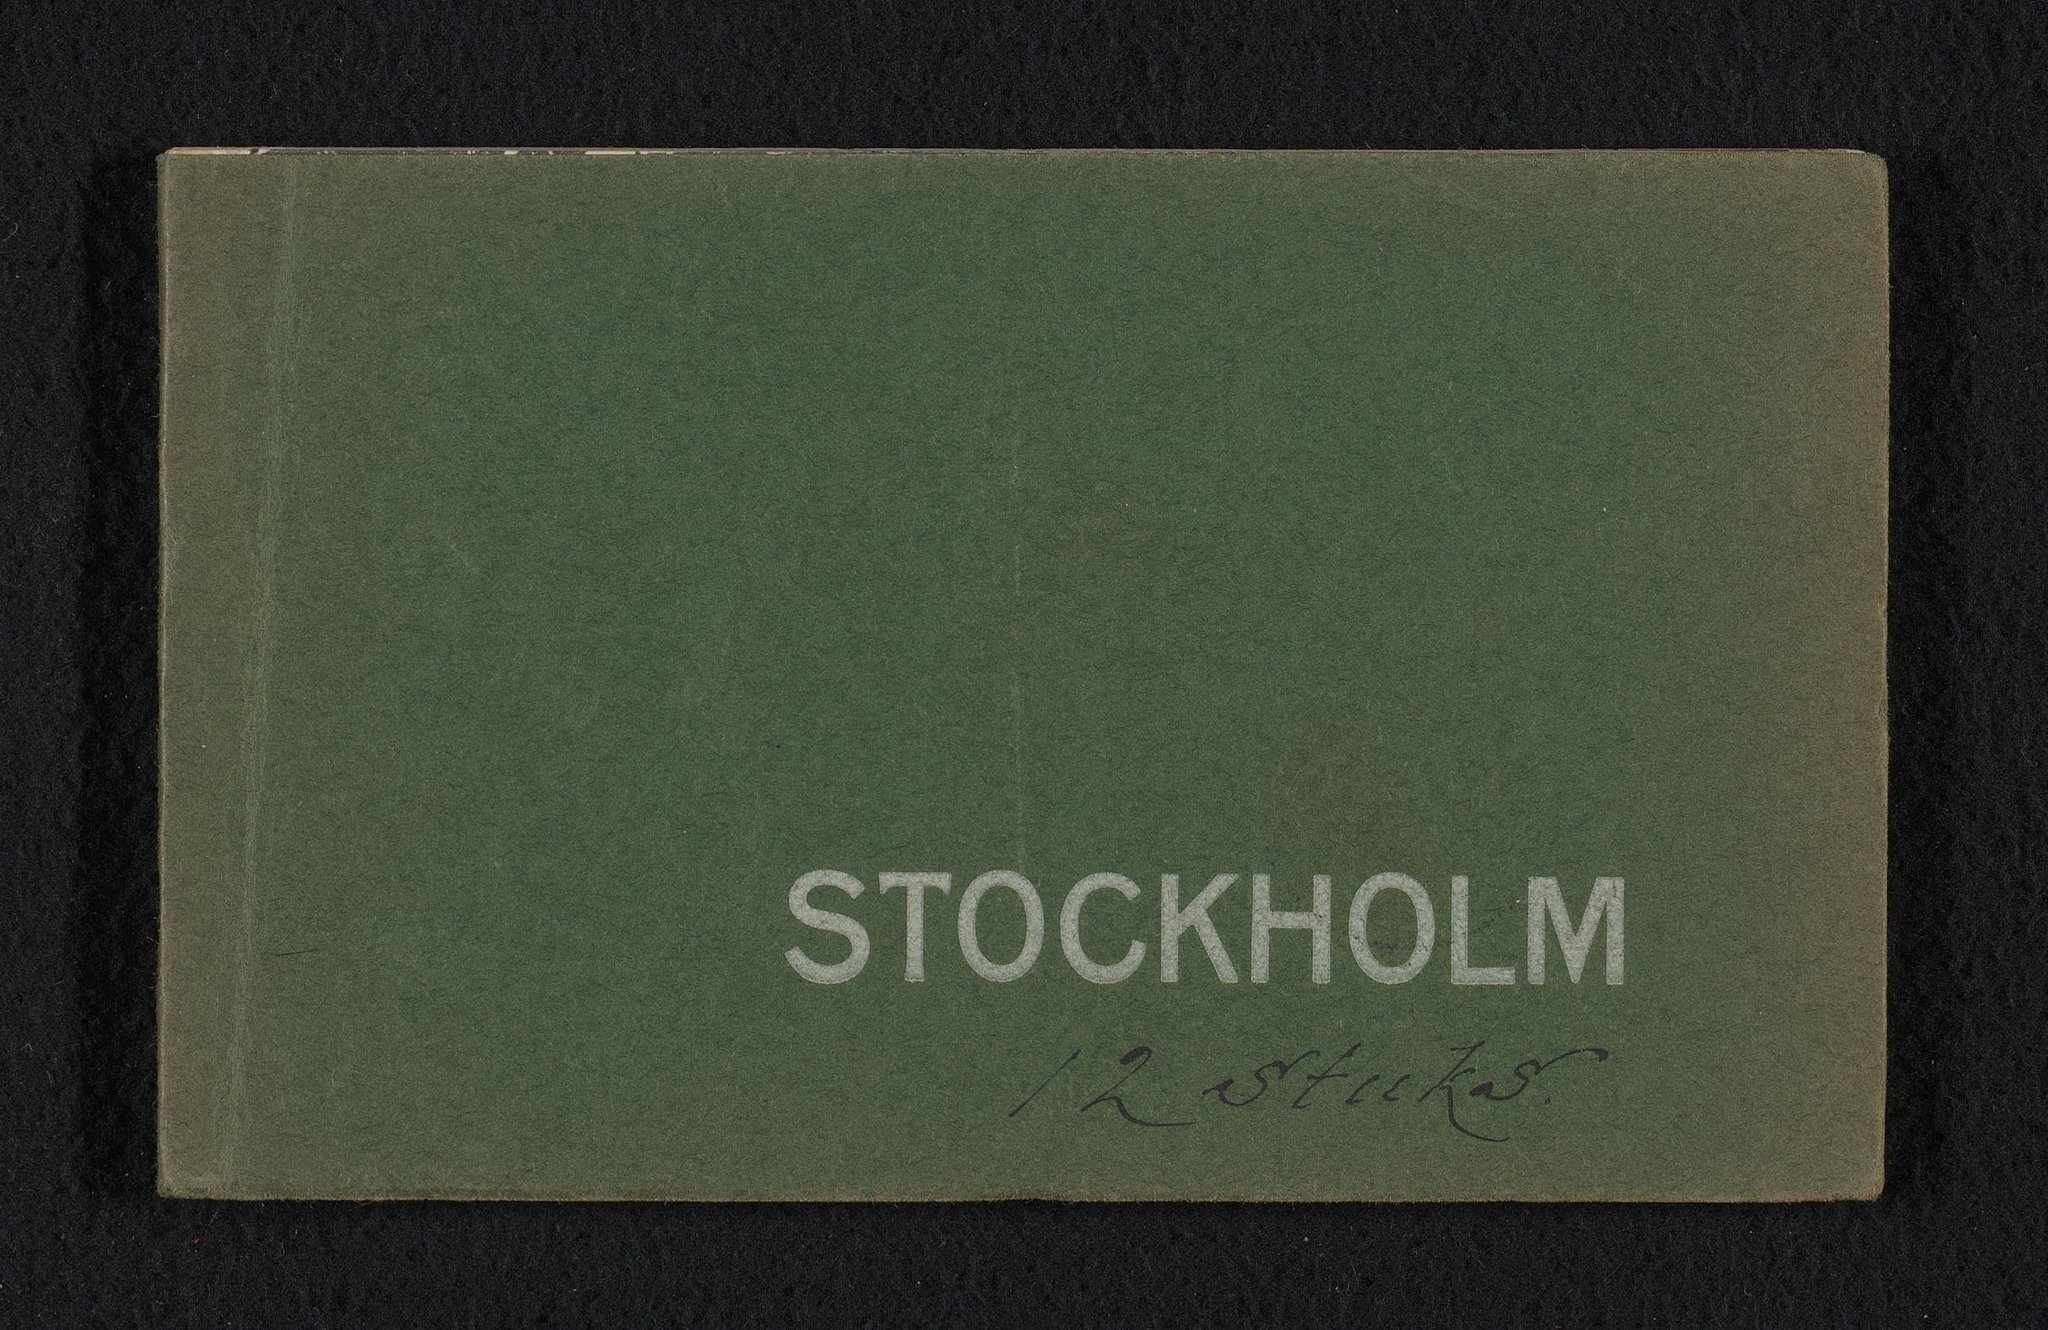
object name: album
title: Album met voorstellingen van Stockholm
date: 1905-1930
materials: paper, cardboard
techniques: photograph, printing, writing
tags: city-view, and landscape with man-made constructions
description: Album met twaalf prentbriefkaarten met voorstellingen van Stockholm. De prentbriefkaarten kunnen eruit gescheurd worden.